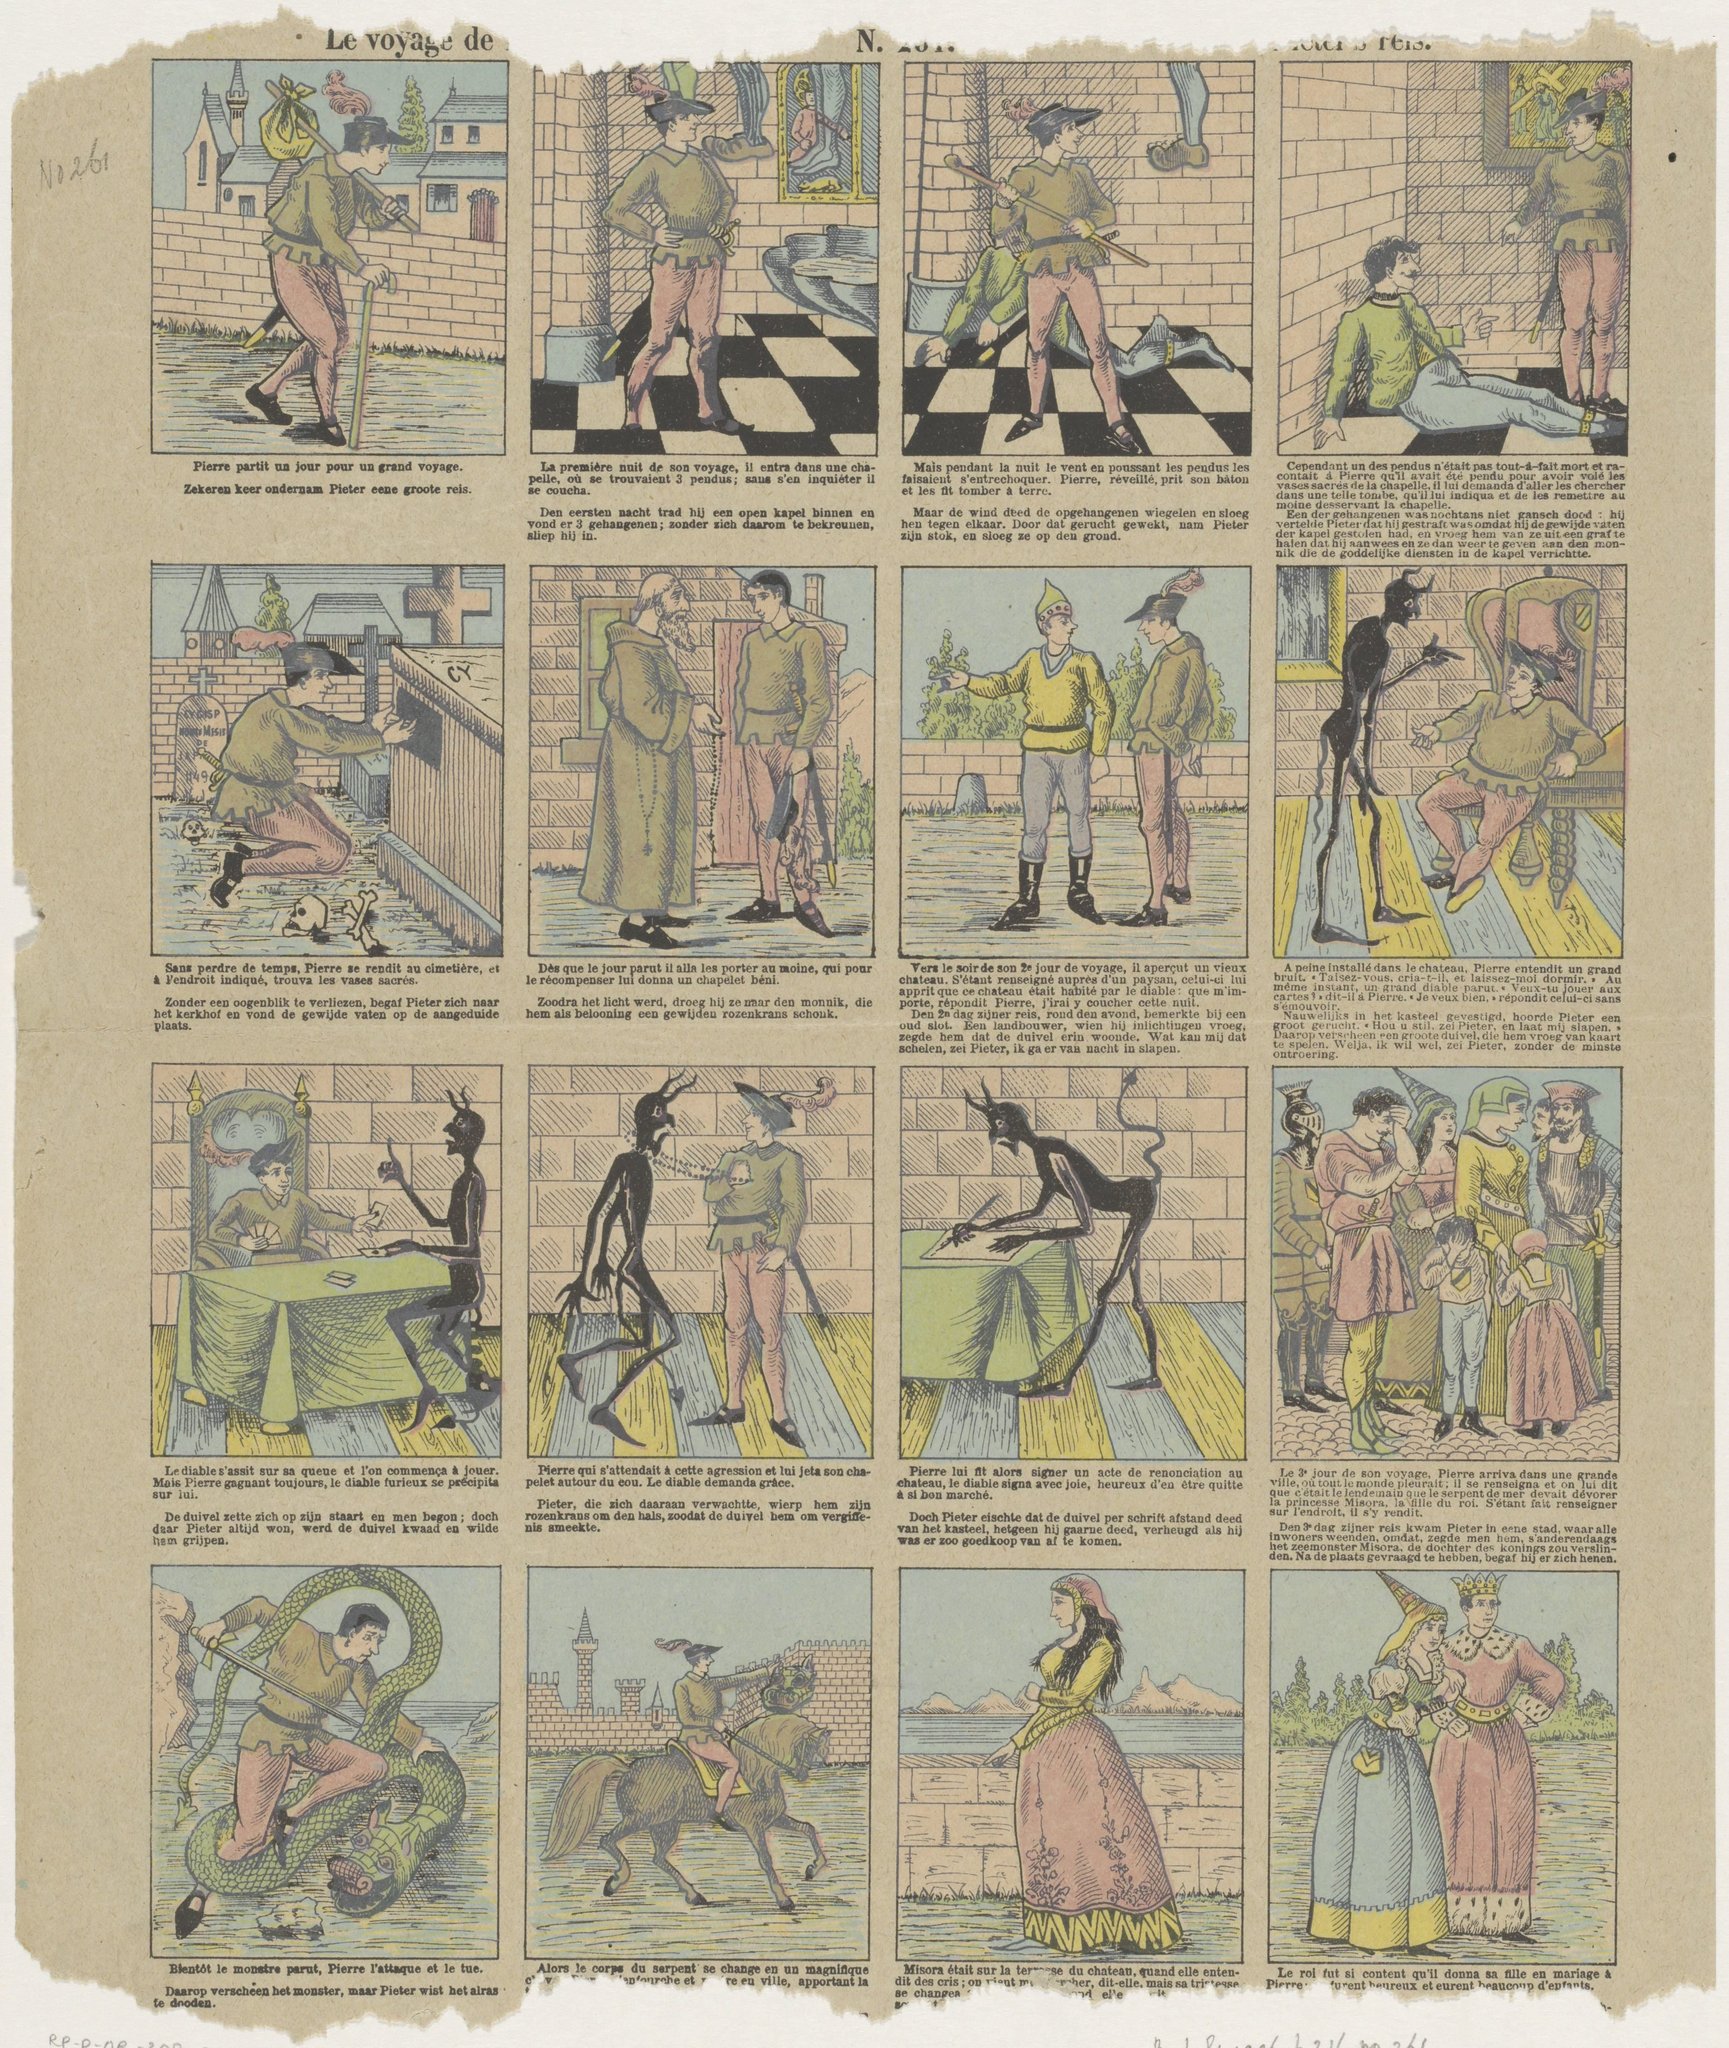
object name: print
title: Le voyage de [Pierre / Pieter's reis]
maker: Anonymous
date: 1833-1911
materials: paper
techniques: lithograph, letterpress printing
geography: turnhout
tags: devil(s) and demons, travelling; tourism, princess, tales and fairy tales, mis-shapen animals; monsters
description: Blad met 16 voorstellingen over de avonturen van Pieter op reis. Onder elke afbeelding een onderschrift in het Nederlands en in het Frans.